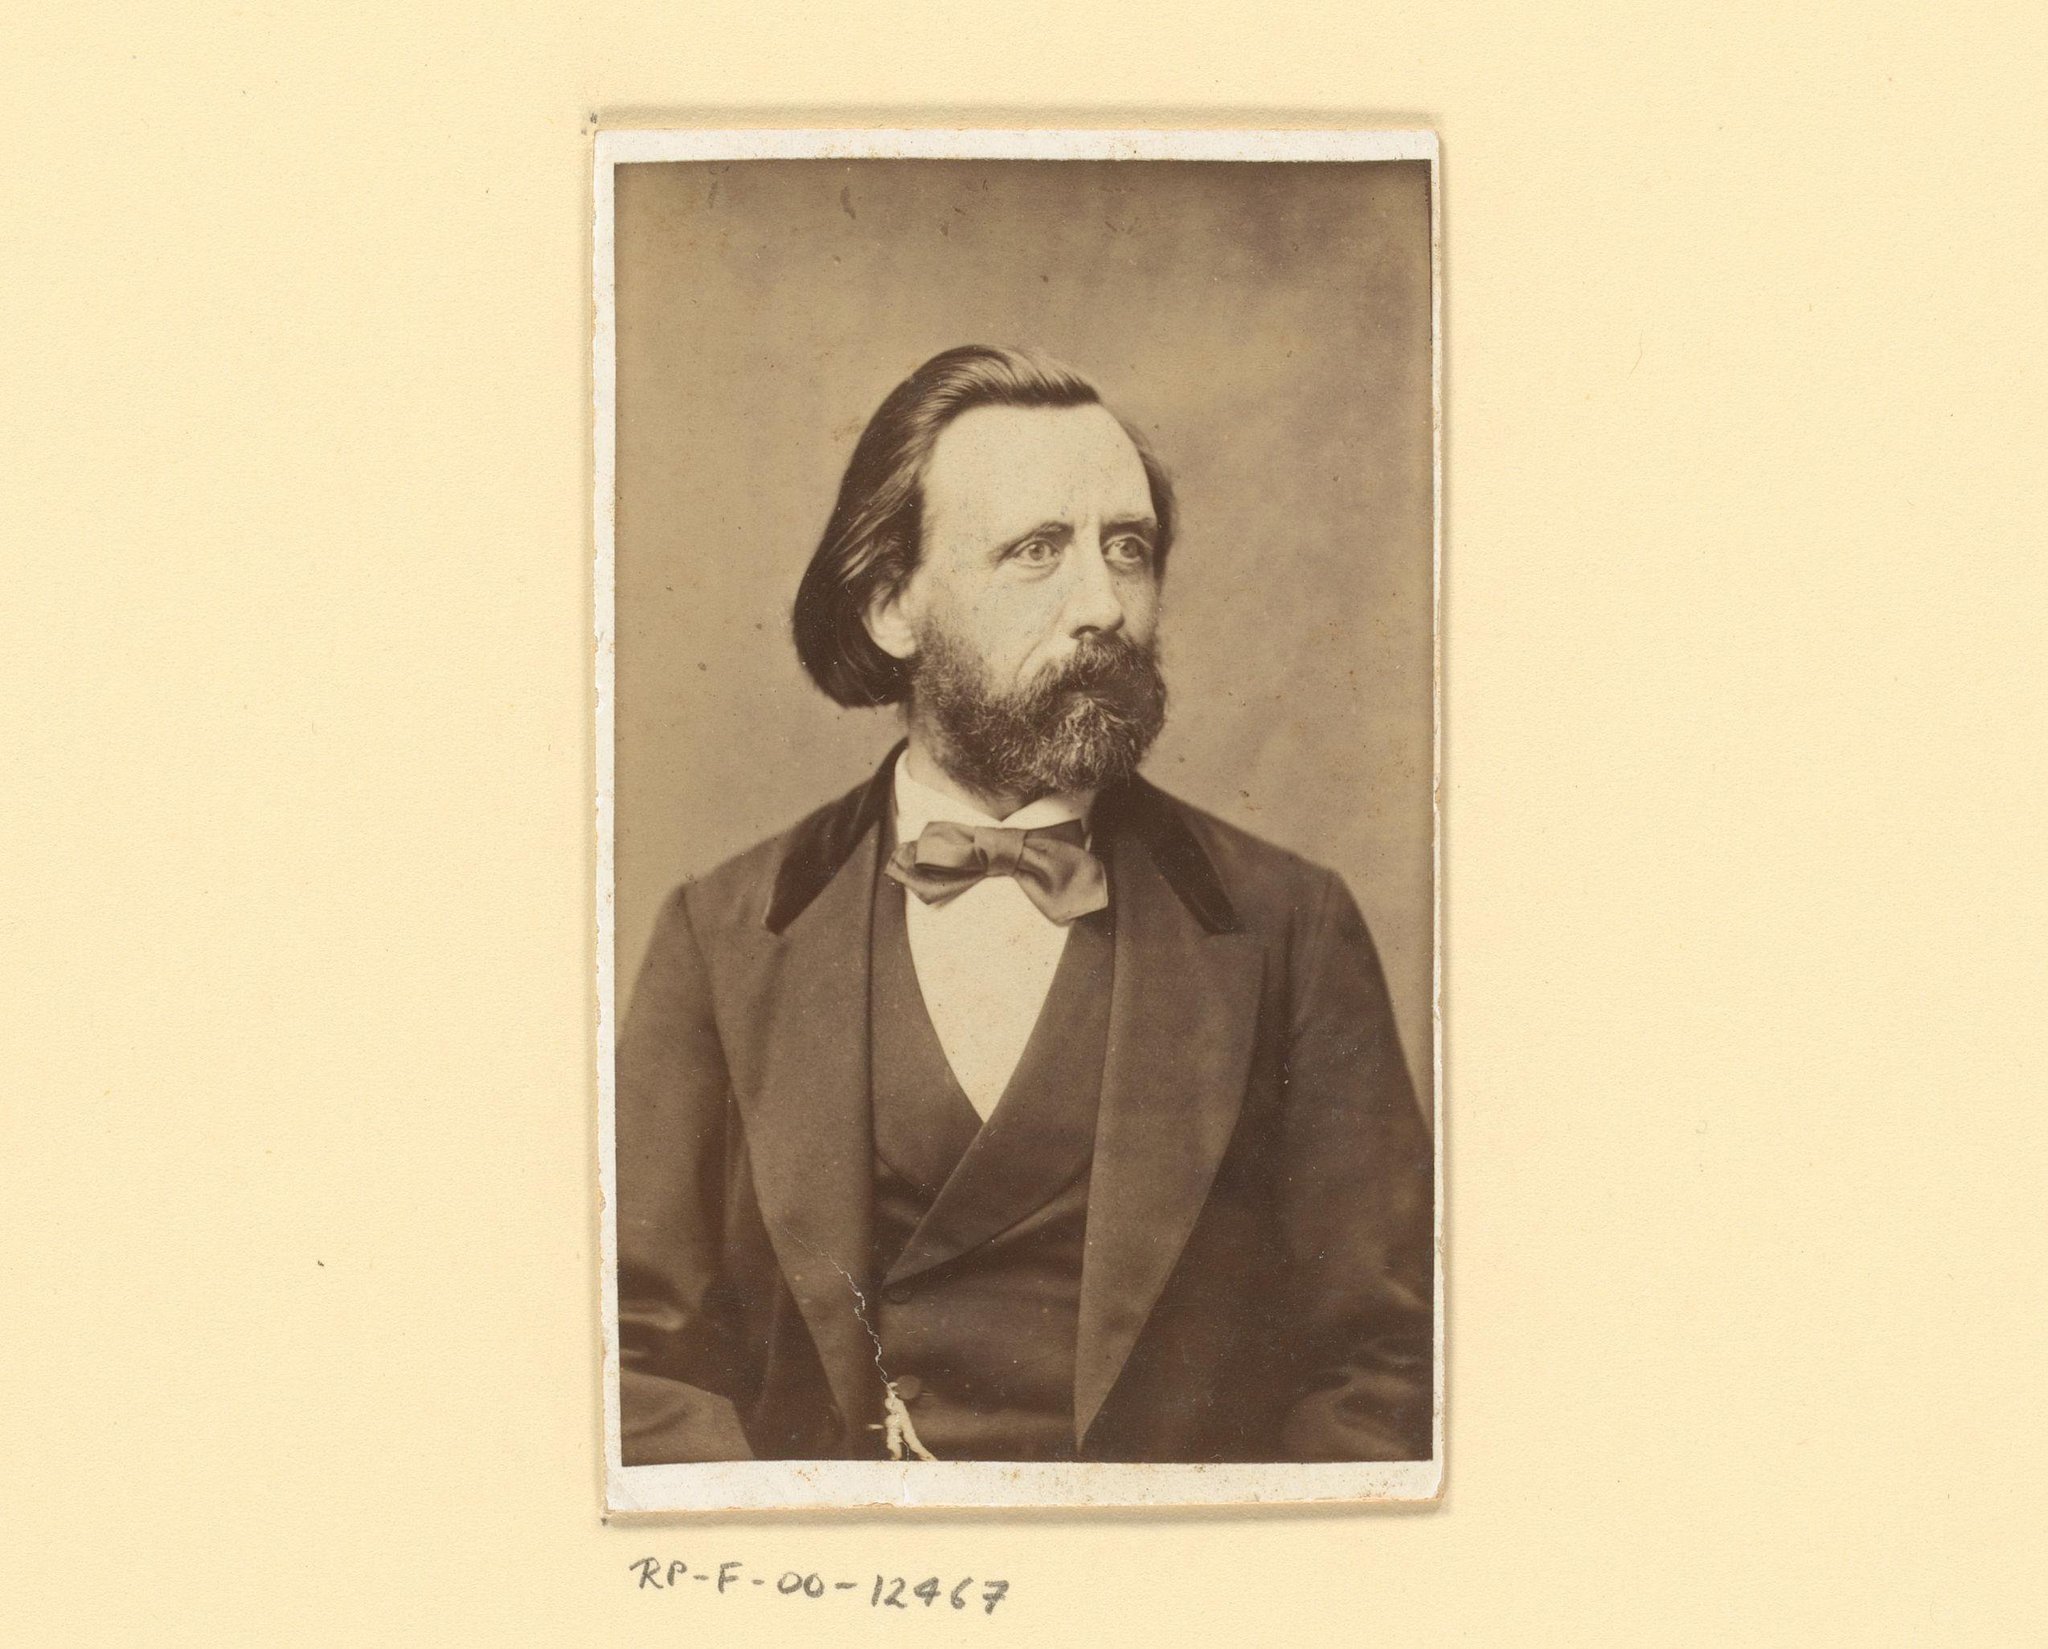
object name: carte de visite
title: Portret van Willem ten Entel jr.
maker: johann heinrich martin bosse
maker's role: fotograaf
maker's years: 1838-1901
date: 1876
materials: cardboard, paper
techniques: albumen print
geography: deventer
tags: historical persons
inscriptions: signature: ‘W. ten Entel/ 1 Oct. 1876.’, inscription: ‘Photogr. Atelier/ M. Bosse (...) ieder klein portret.’